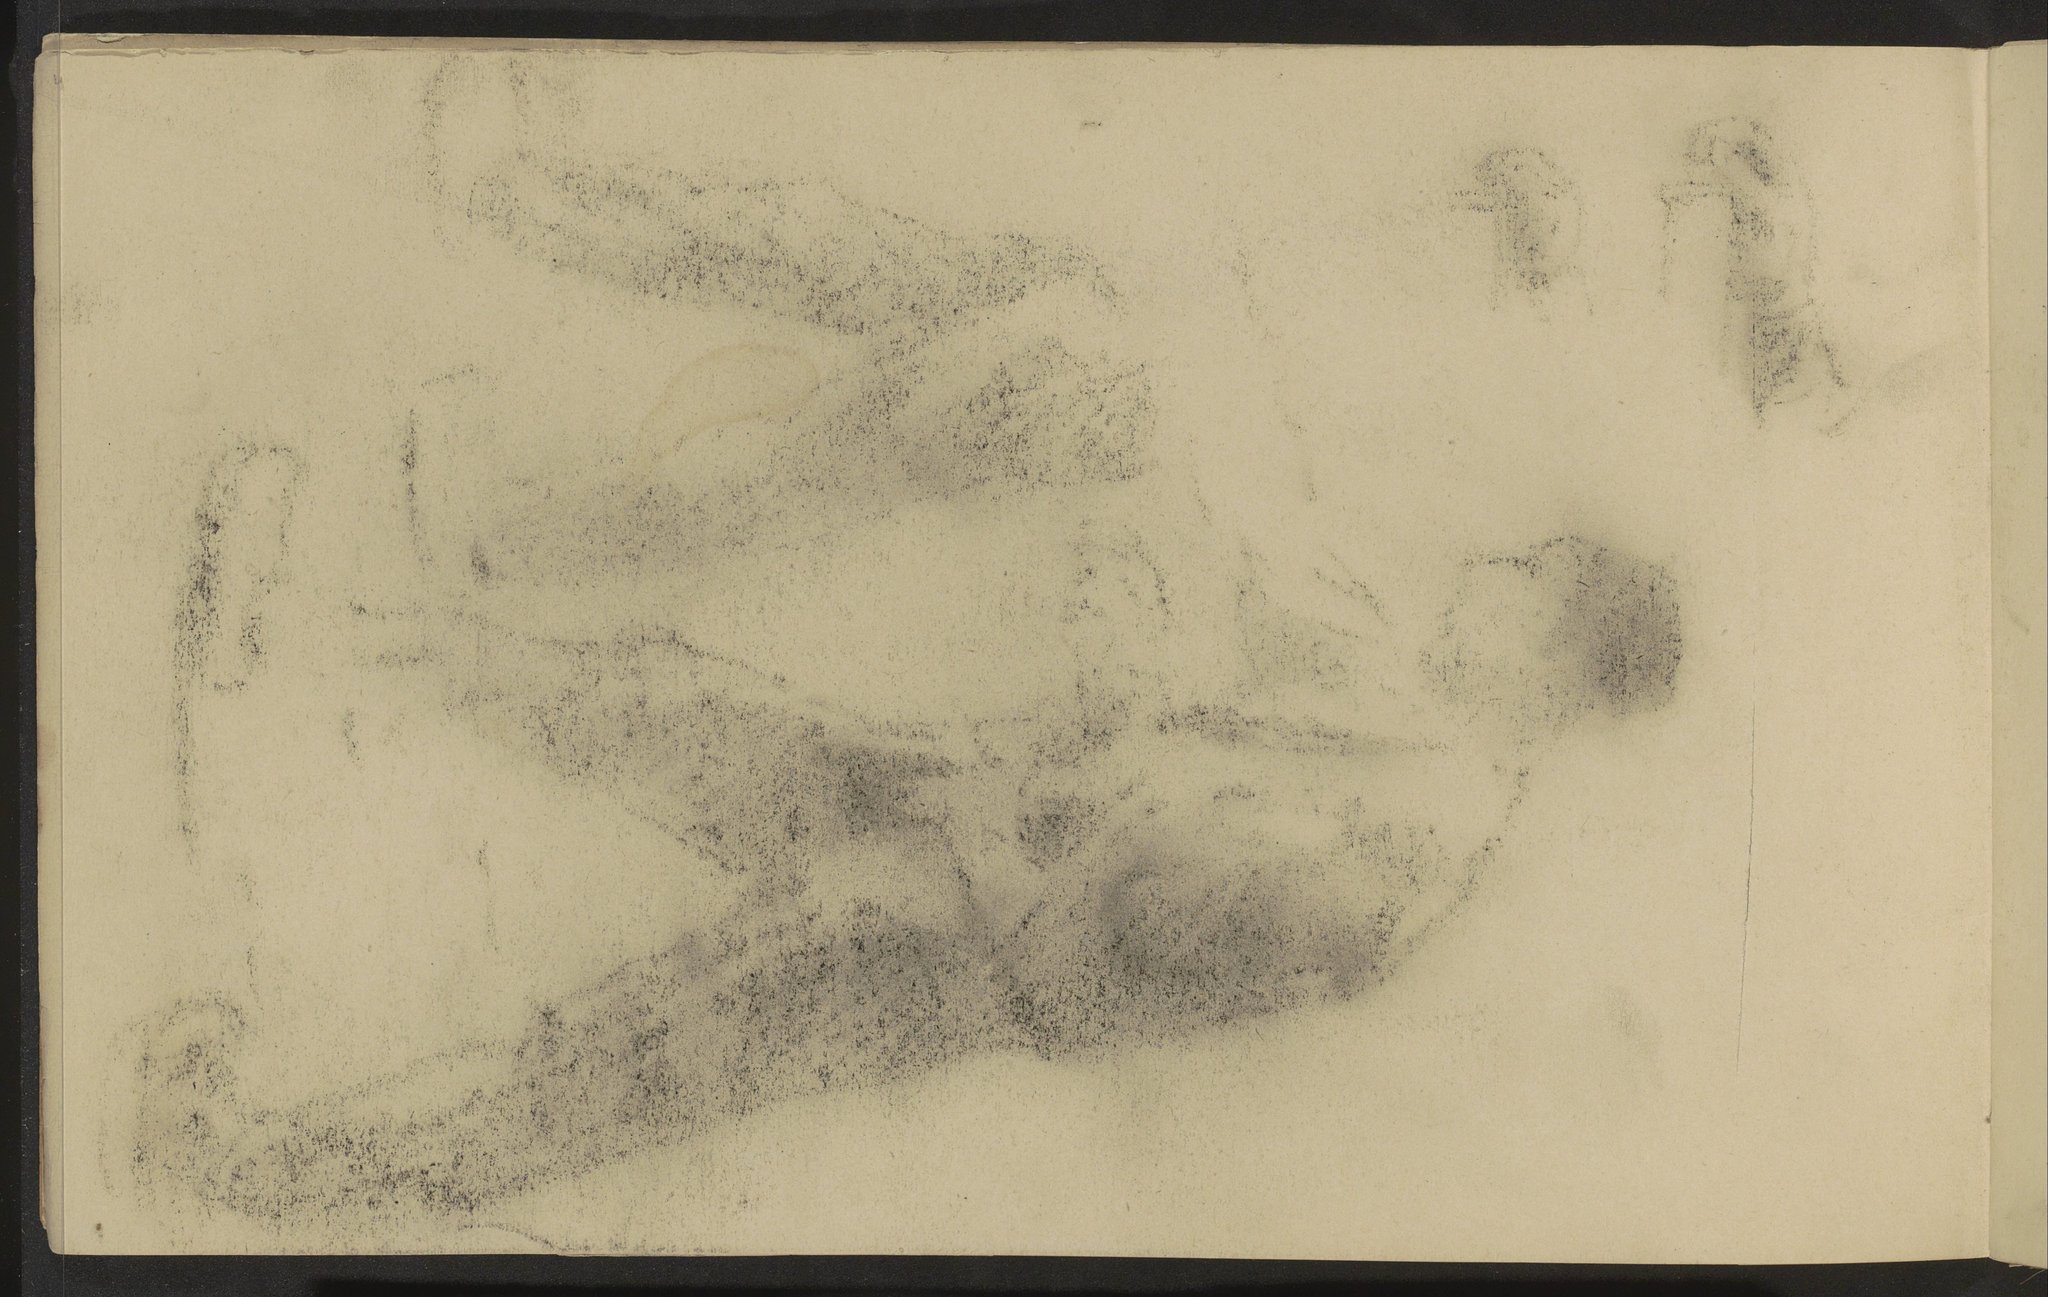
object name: sketchbook leaf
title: Abklatsch van de krijttekening op pagina 5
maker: willem witsen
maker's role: draughtsman, painter, print maker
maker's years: 1860-1923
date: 1897-1910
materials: paper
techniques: printmaking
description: Pagina 4 uit een schetsboek met 19 bladen.